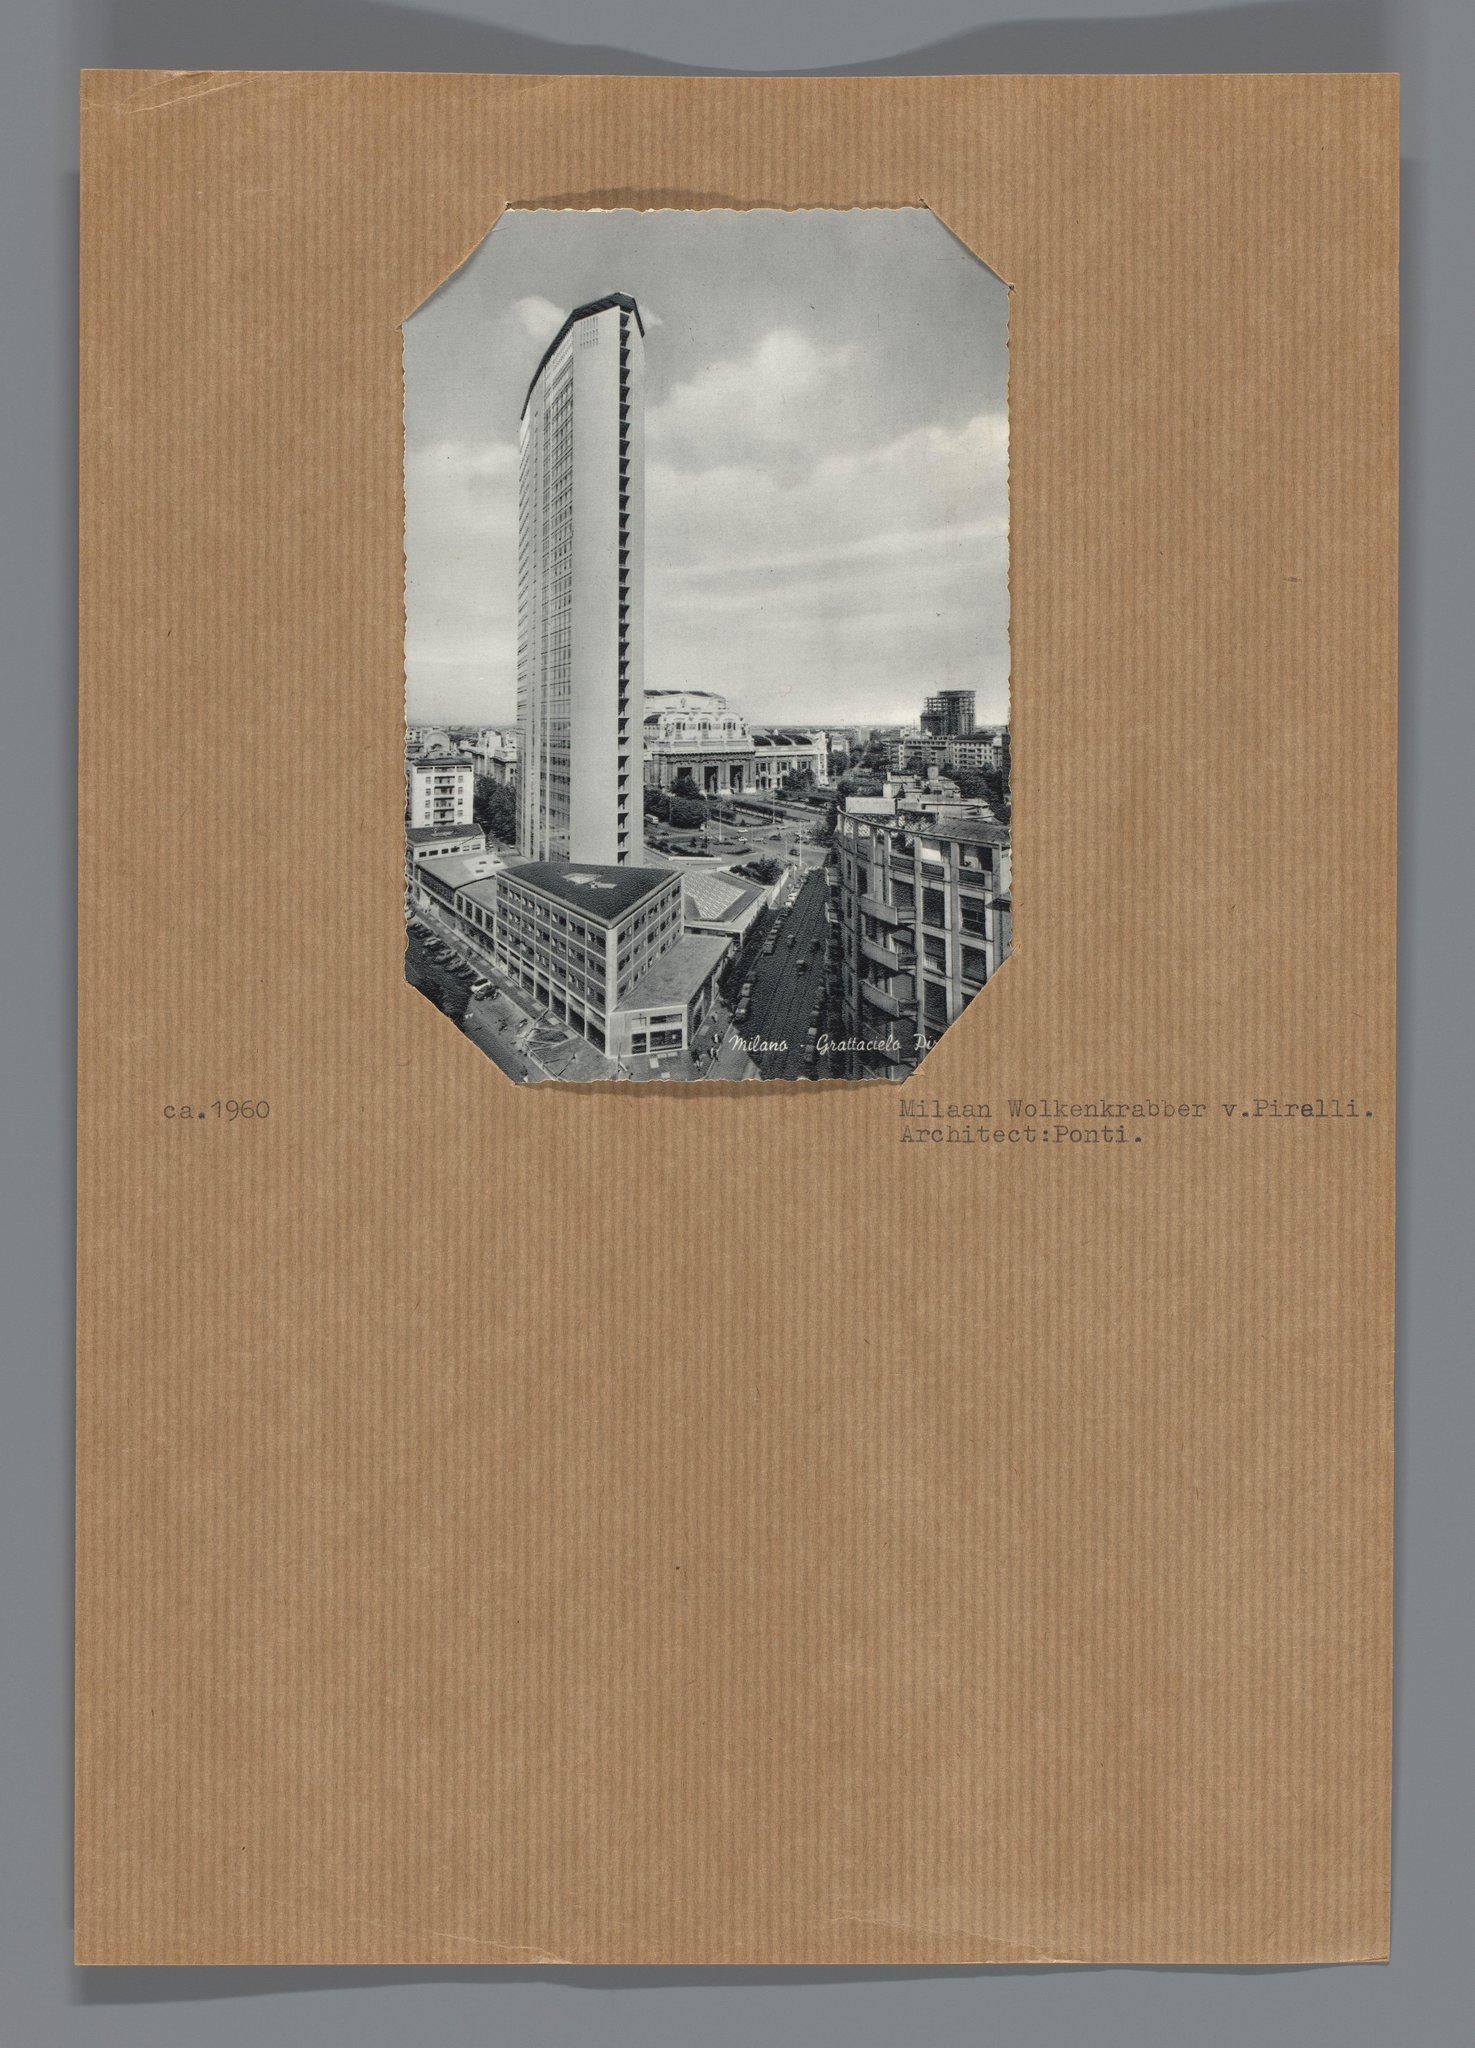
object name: photograph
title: Italië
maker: Anonymous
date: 1880-1910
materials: photographic support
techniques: albumen print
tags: italy